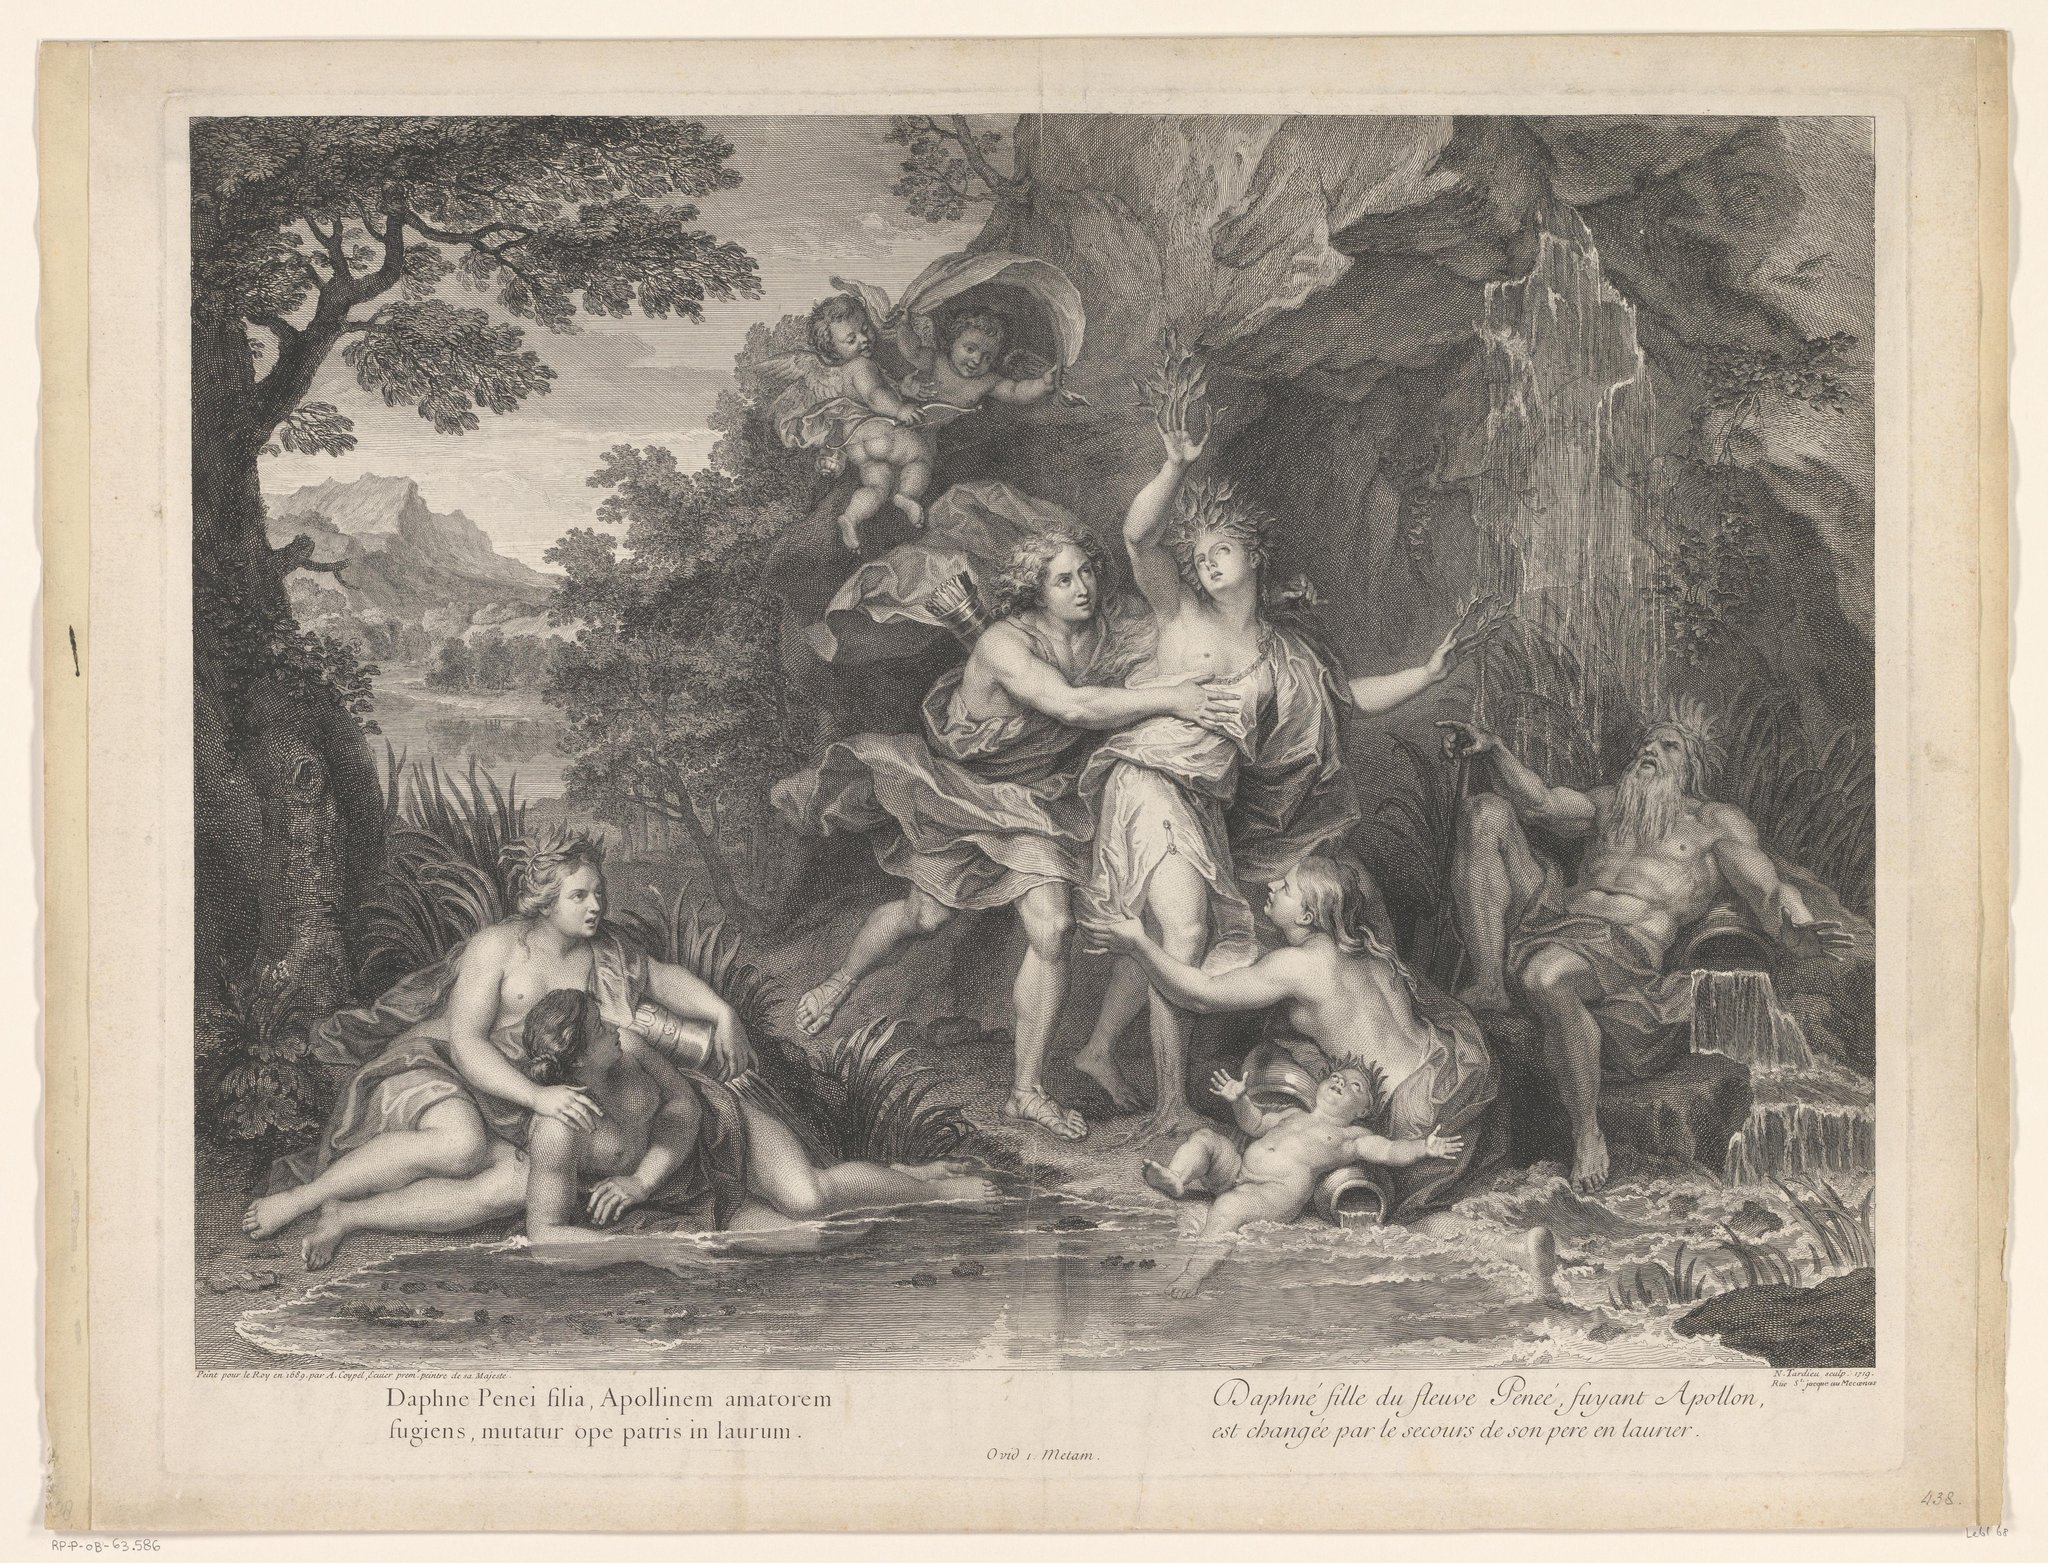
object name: print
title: Daphne en Apollo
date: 1719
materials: paper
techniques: engraving, etching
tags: apollo pursuing the nymph daphne (as yet not metamorphosed), daphne changed into a laurel-tree: while fleeing from apollo, daphne is changed into a laurel-tree by her father peneus (ovid, metamorphoses i 548)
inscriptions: collector's mark: Lugt 240